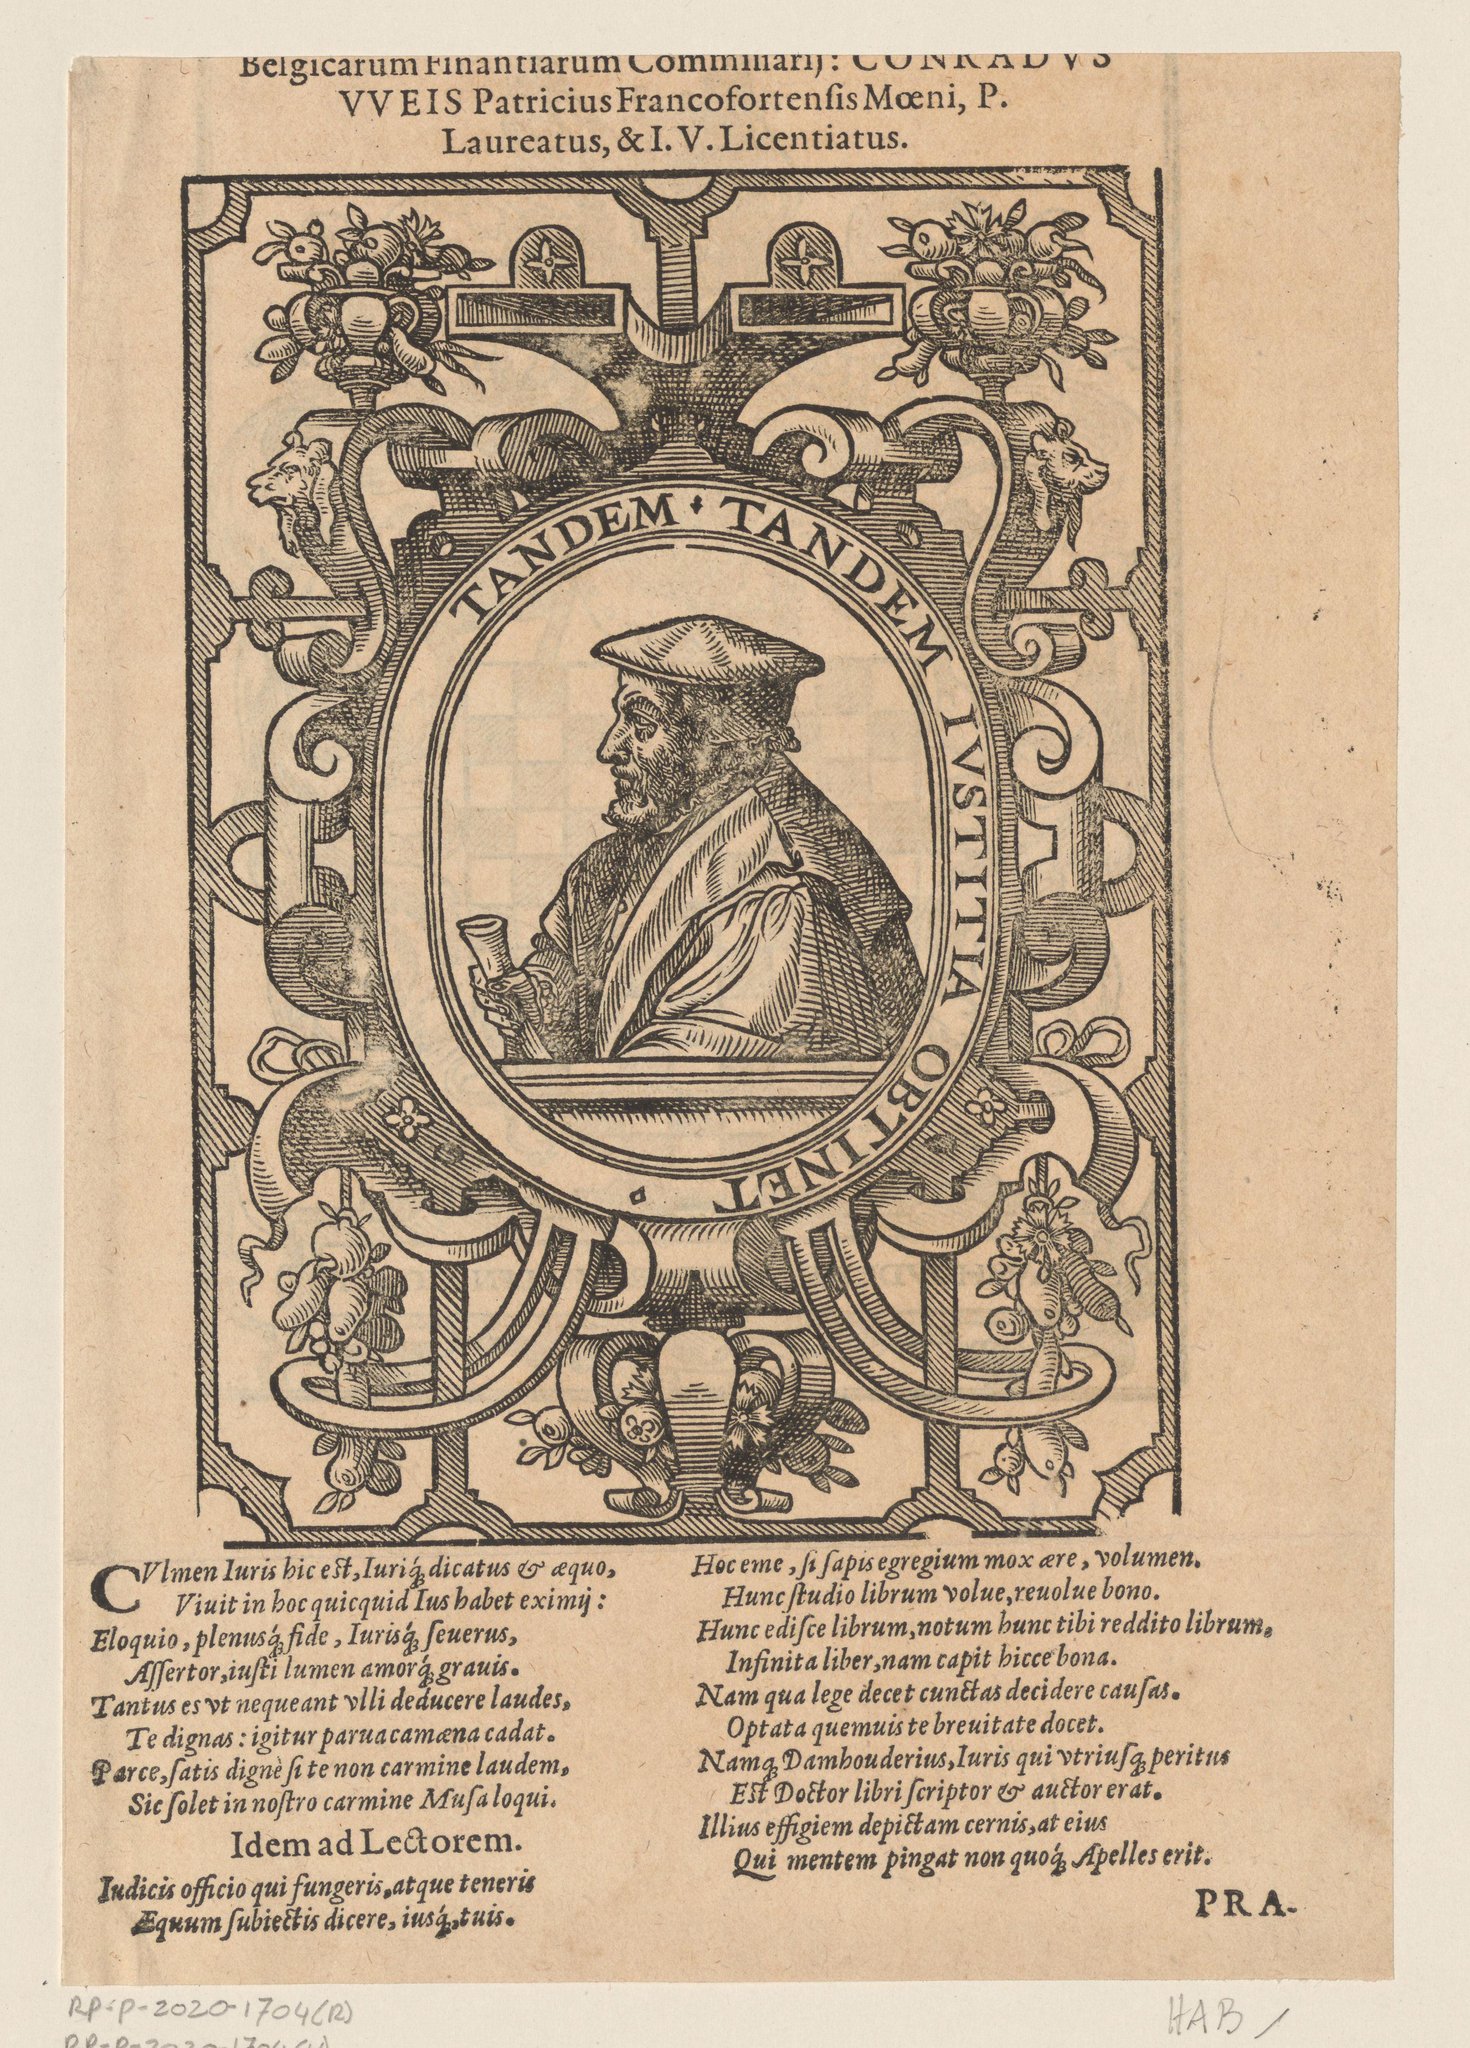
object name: print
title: Portret van Joos de Damhouder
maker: Anonymous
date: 1570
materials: paper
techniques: letterpress printing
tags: bruges, antwerp, historical persons, counsellor, portrait of a writer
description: Huidige staat van prent met tekst op verso gebruikt in: Damhouder, Joos de. Praxis rerum criminalium (...). Antwerpen: Joannes Bellerus (I), 1570.